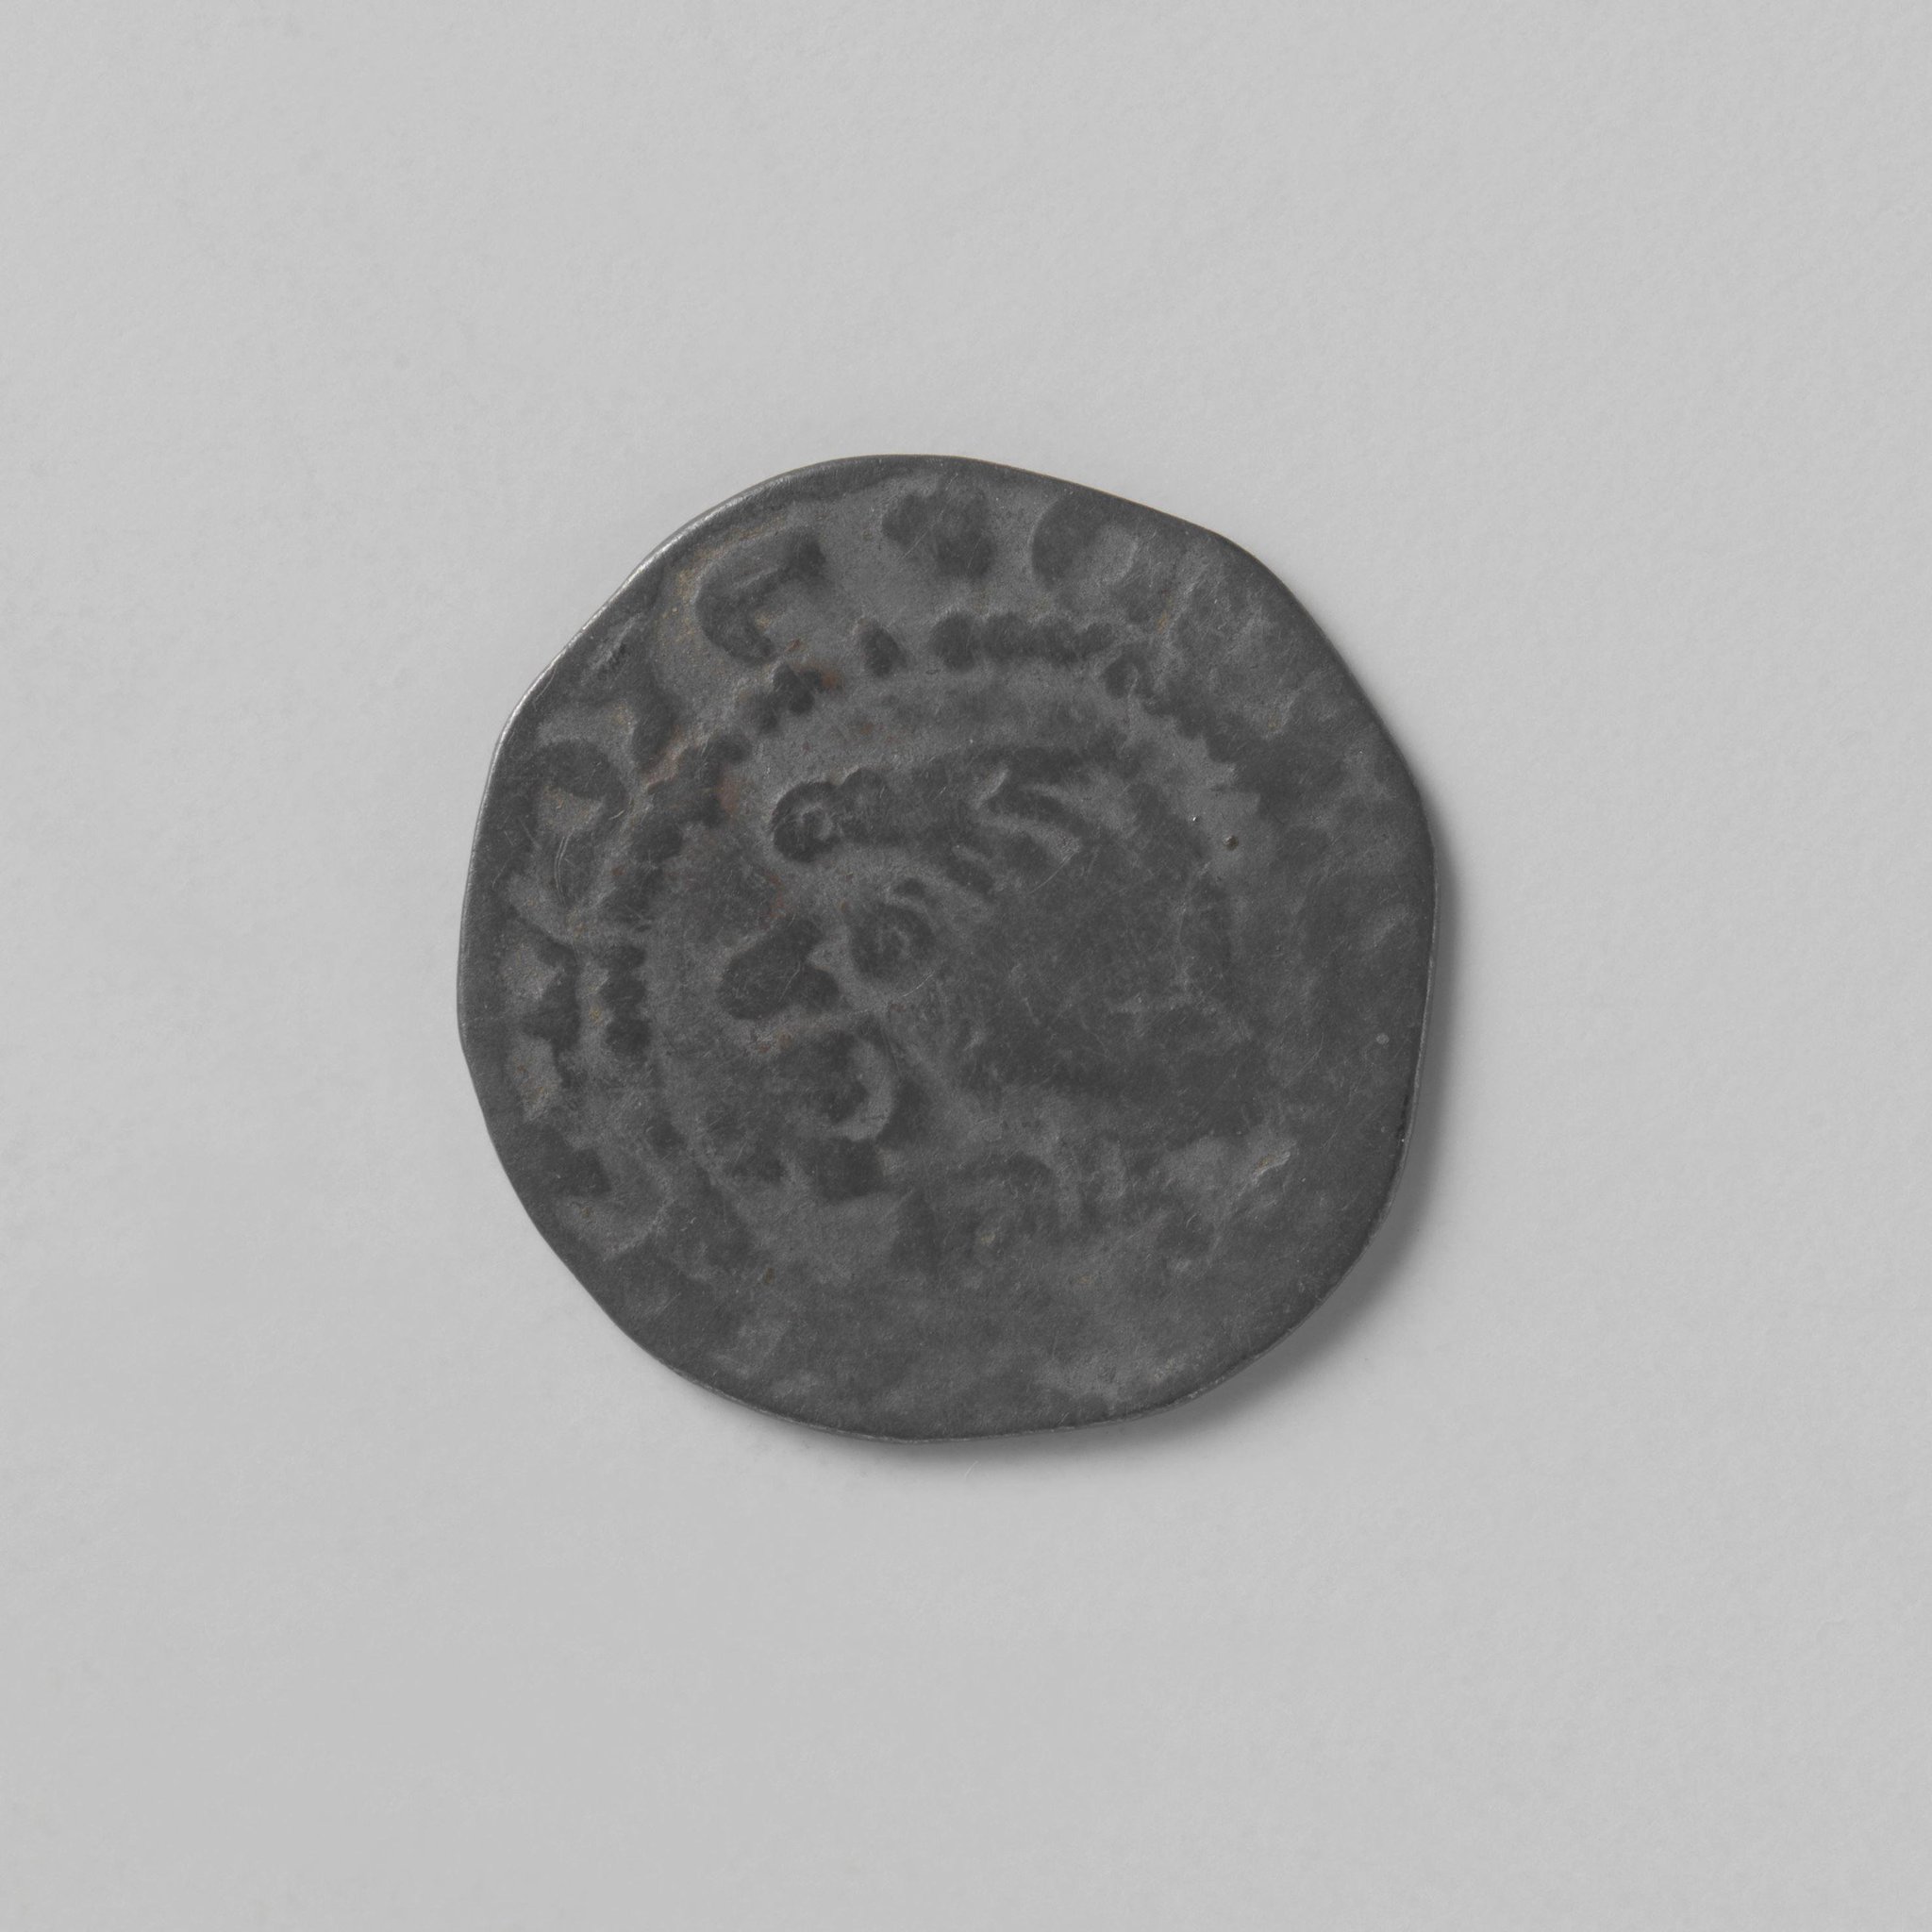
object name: penny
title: Holland, Floris V, penning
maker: floris v (graaf van holland en zeeland)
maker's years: 1254-1296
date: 1284-1286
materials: silver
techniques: striking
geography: dordrecht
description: Zilveren munt. Voorzijde: hoofd met gravenmuts naar links. Keerzijde: lang dubbellijnig kruis, in hoeken vijfpuntige spoorradertjes.